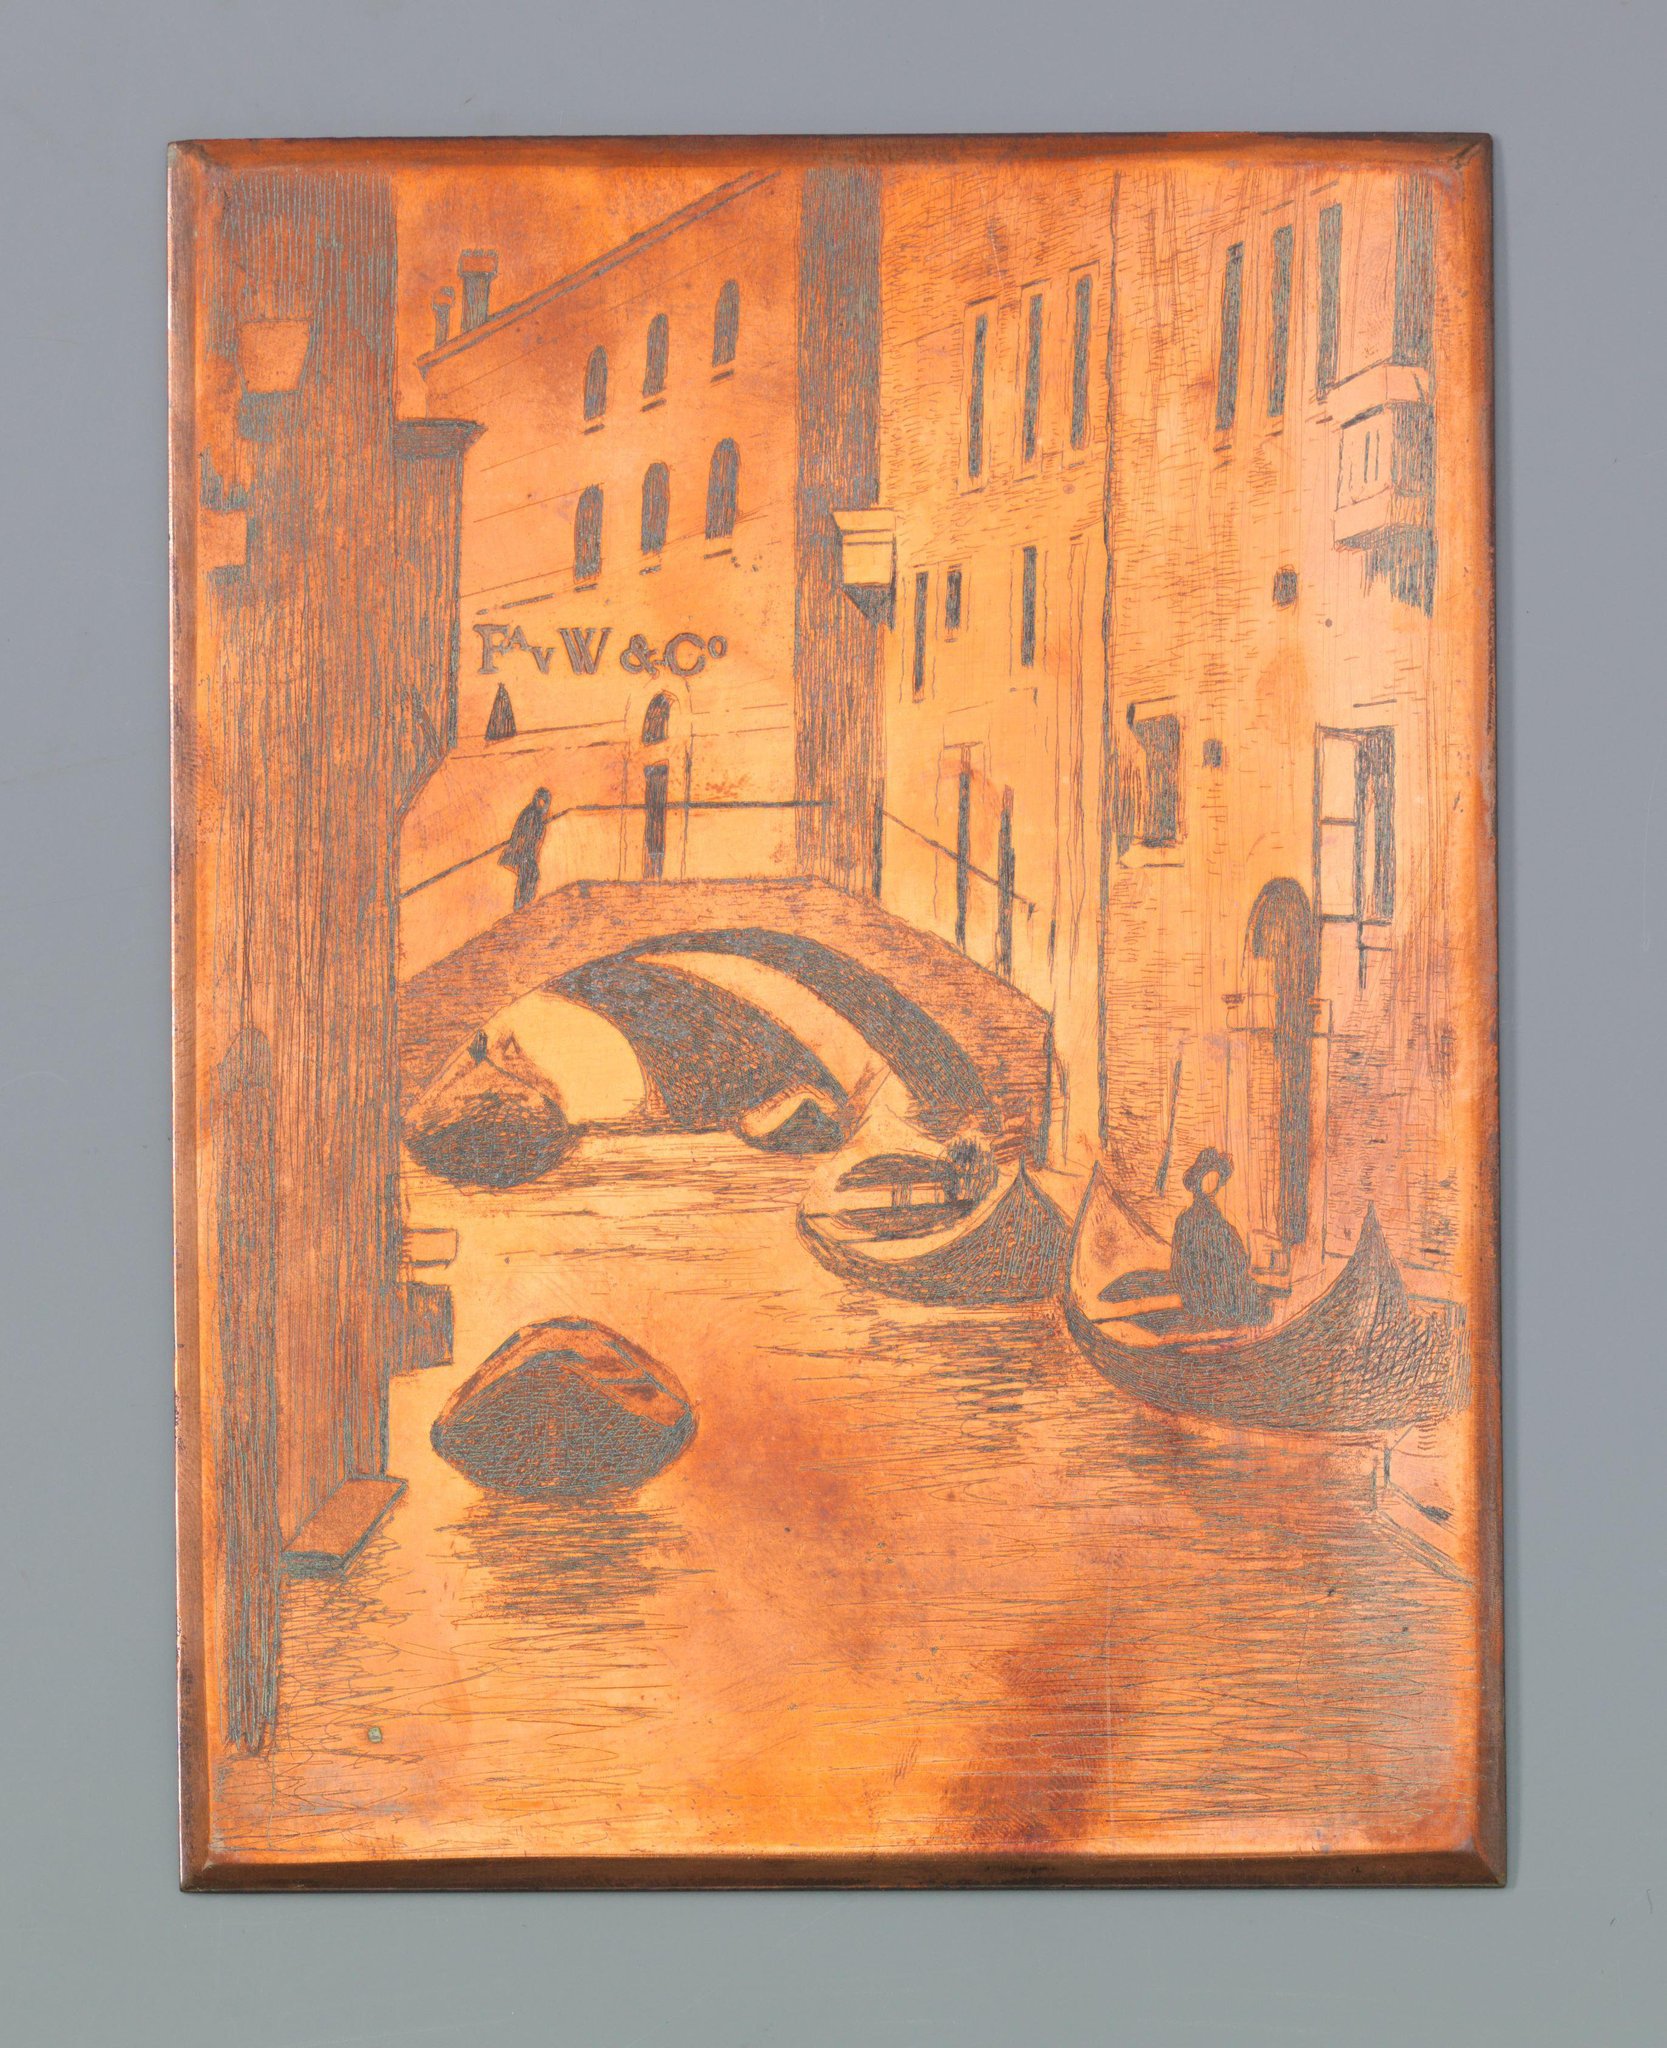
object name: copper plate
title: Brug over de Rio di San Toma, Venetië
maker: willem witsen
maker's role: draughtsman, painter, print maker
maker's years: 1860-1923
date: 1914-1919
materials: copper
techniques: etching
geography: venice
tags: rio di san toma